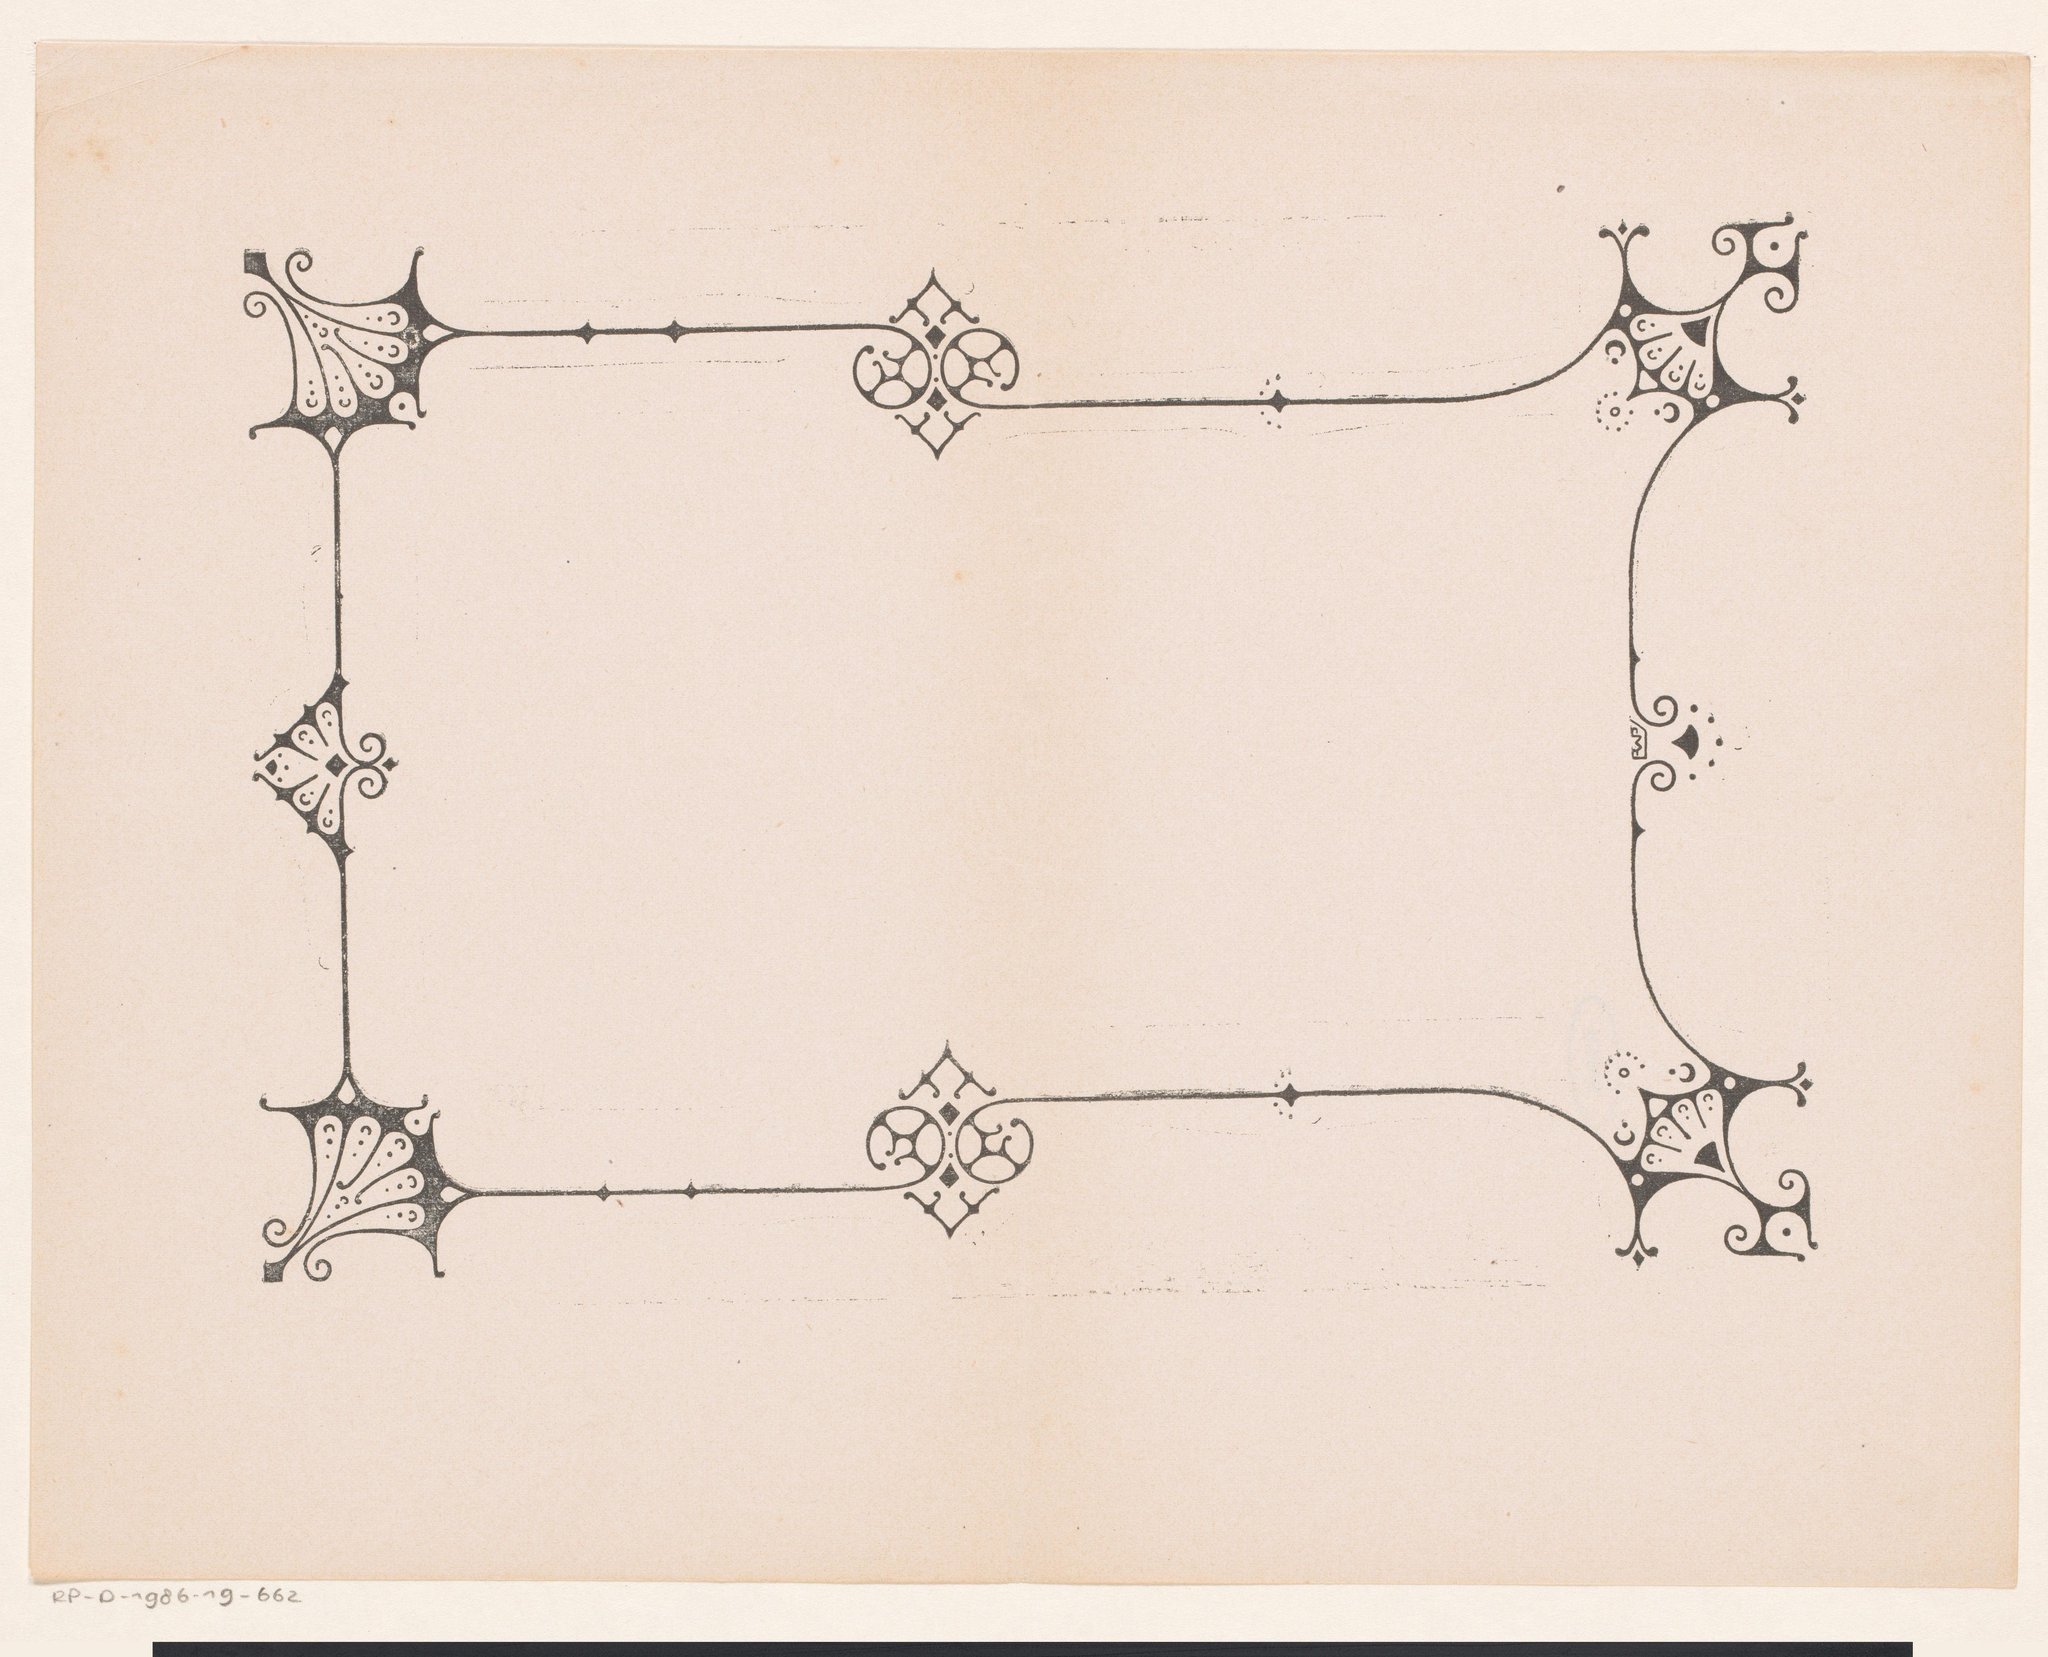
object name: photomechanical print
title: Kader voor Elsevier's Geïllustreerd Maandschrift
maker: reinier willem petrus de vries (1874-1953)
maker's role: draughtsman, print maker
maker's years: 1874-1953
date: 1905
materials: paper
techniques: printing block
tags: ornaments ~ art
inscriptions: collector's mark: ‘R:MVS.’